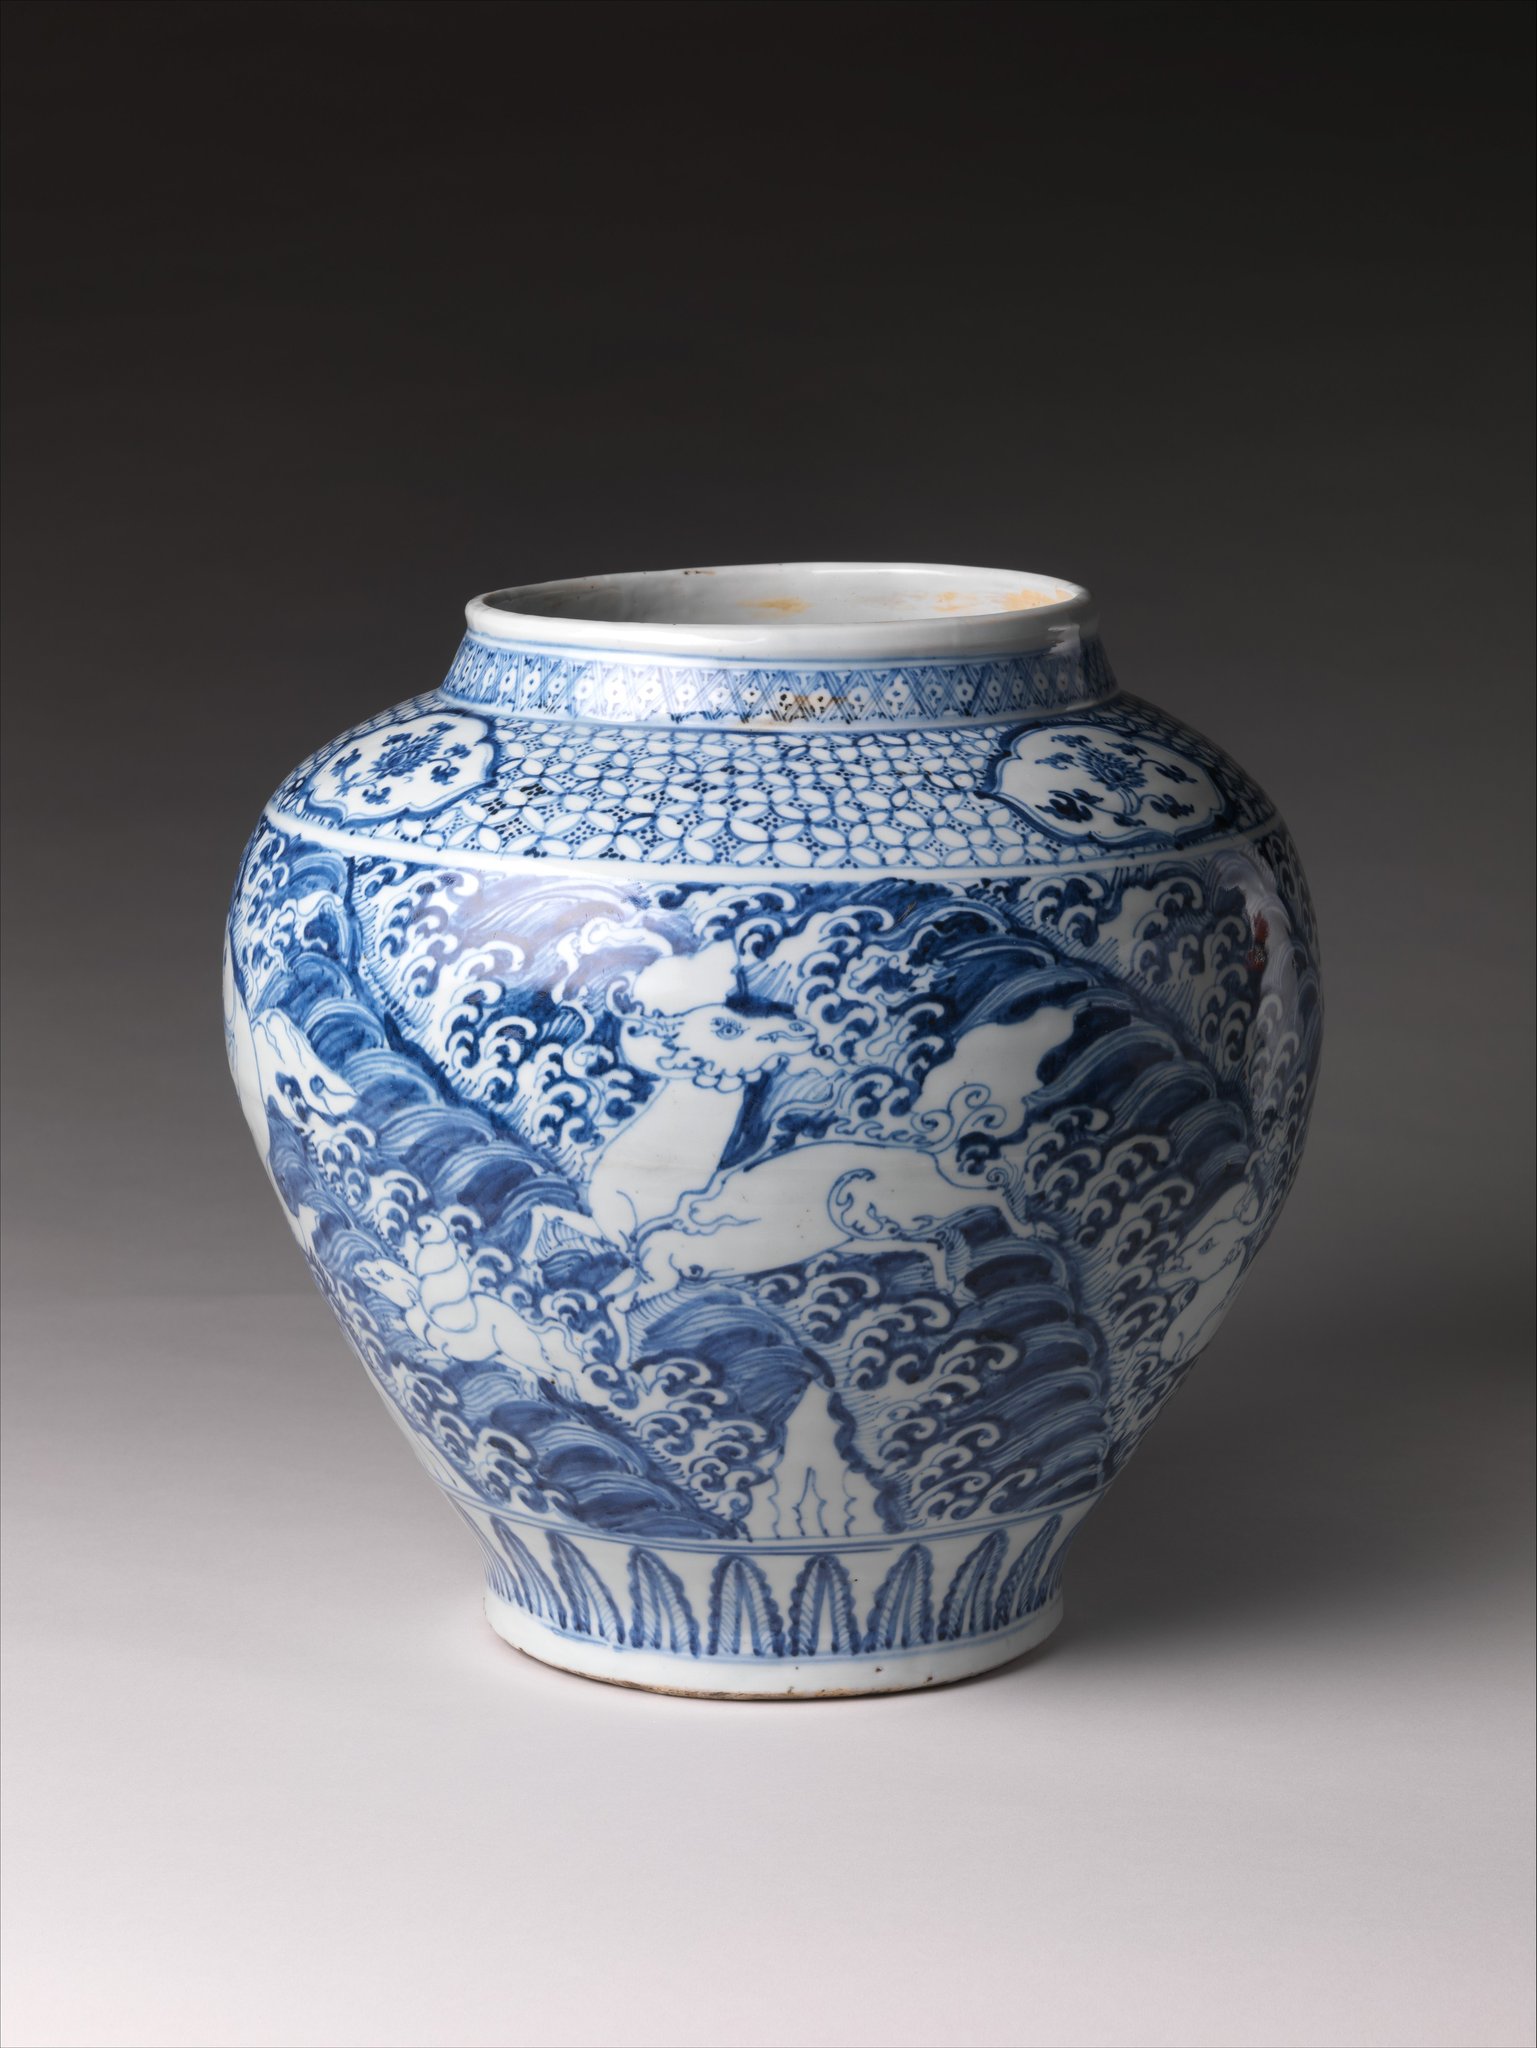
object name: jar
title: Jar with Winged Animals over Waves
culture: chinese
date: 1434-1466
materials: cobalt, glaze, porcelain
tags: animals,waves